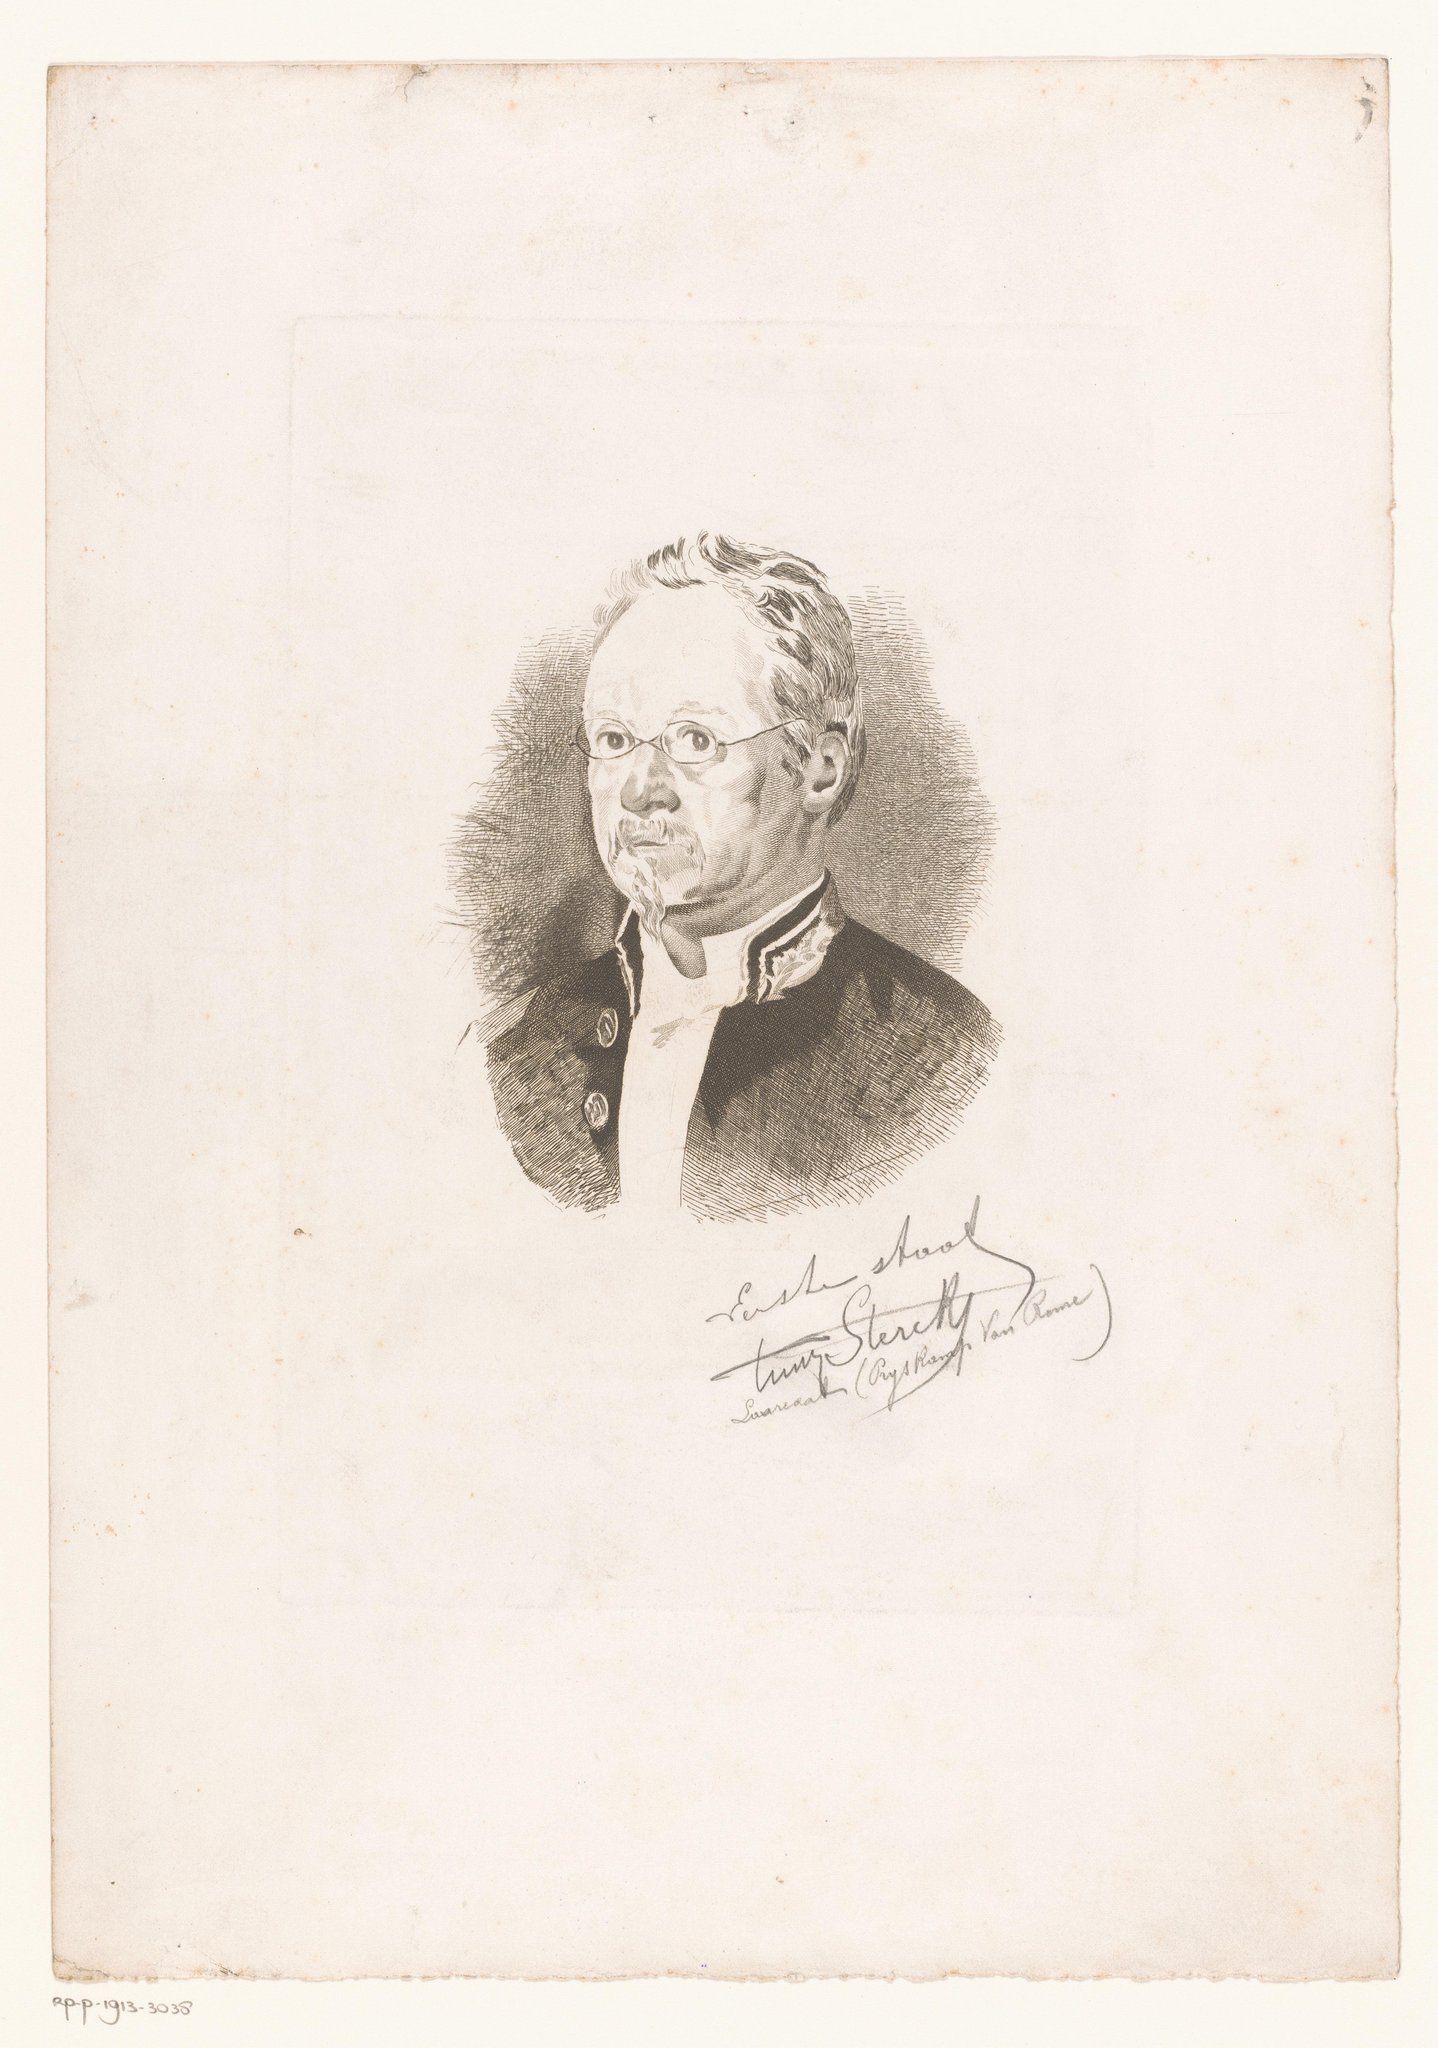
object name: print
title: Portret van Emile Allewaert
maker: arthur sterck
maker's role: print maker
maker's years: 1868-1897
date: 1890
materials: paper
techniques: drypoint, etching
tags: politician, historical persons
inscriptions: collector's mark: Lugt 2228